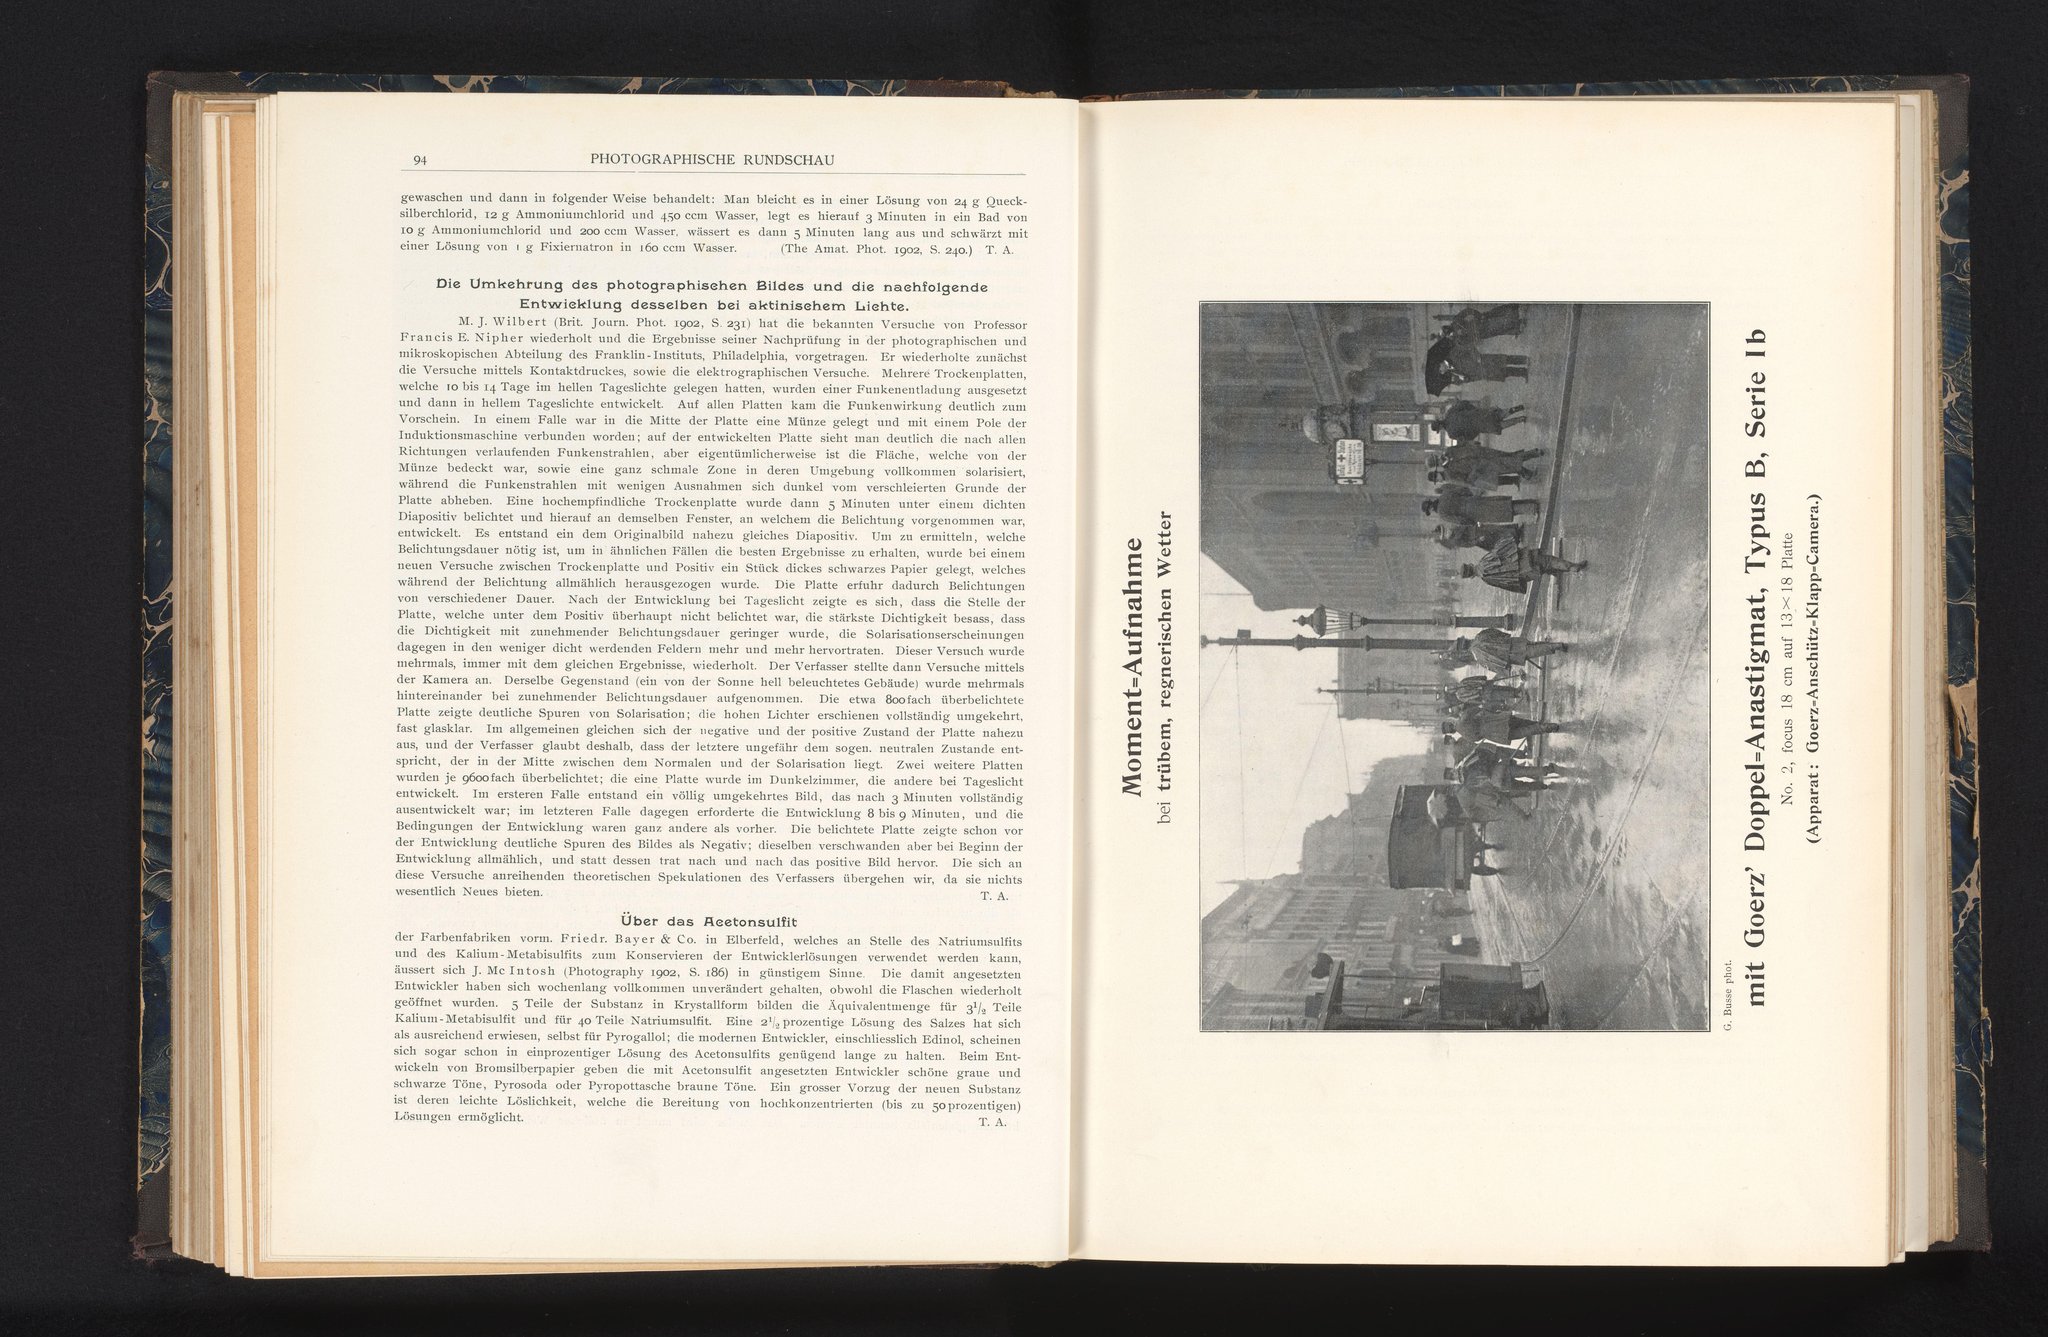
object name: photomechanical print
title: Gezicht op een straat met voetgangers en trams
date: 1897-1902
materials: paper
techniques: autotype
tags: tram, street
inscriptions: inscription: ‘Moment = Aufnahme/ bei trüben, regnerischen Wetter/ mit Goerz' Doppel = Amastigmat, (...)’